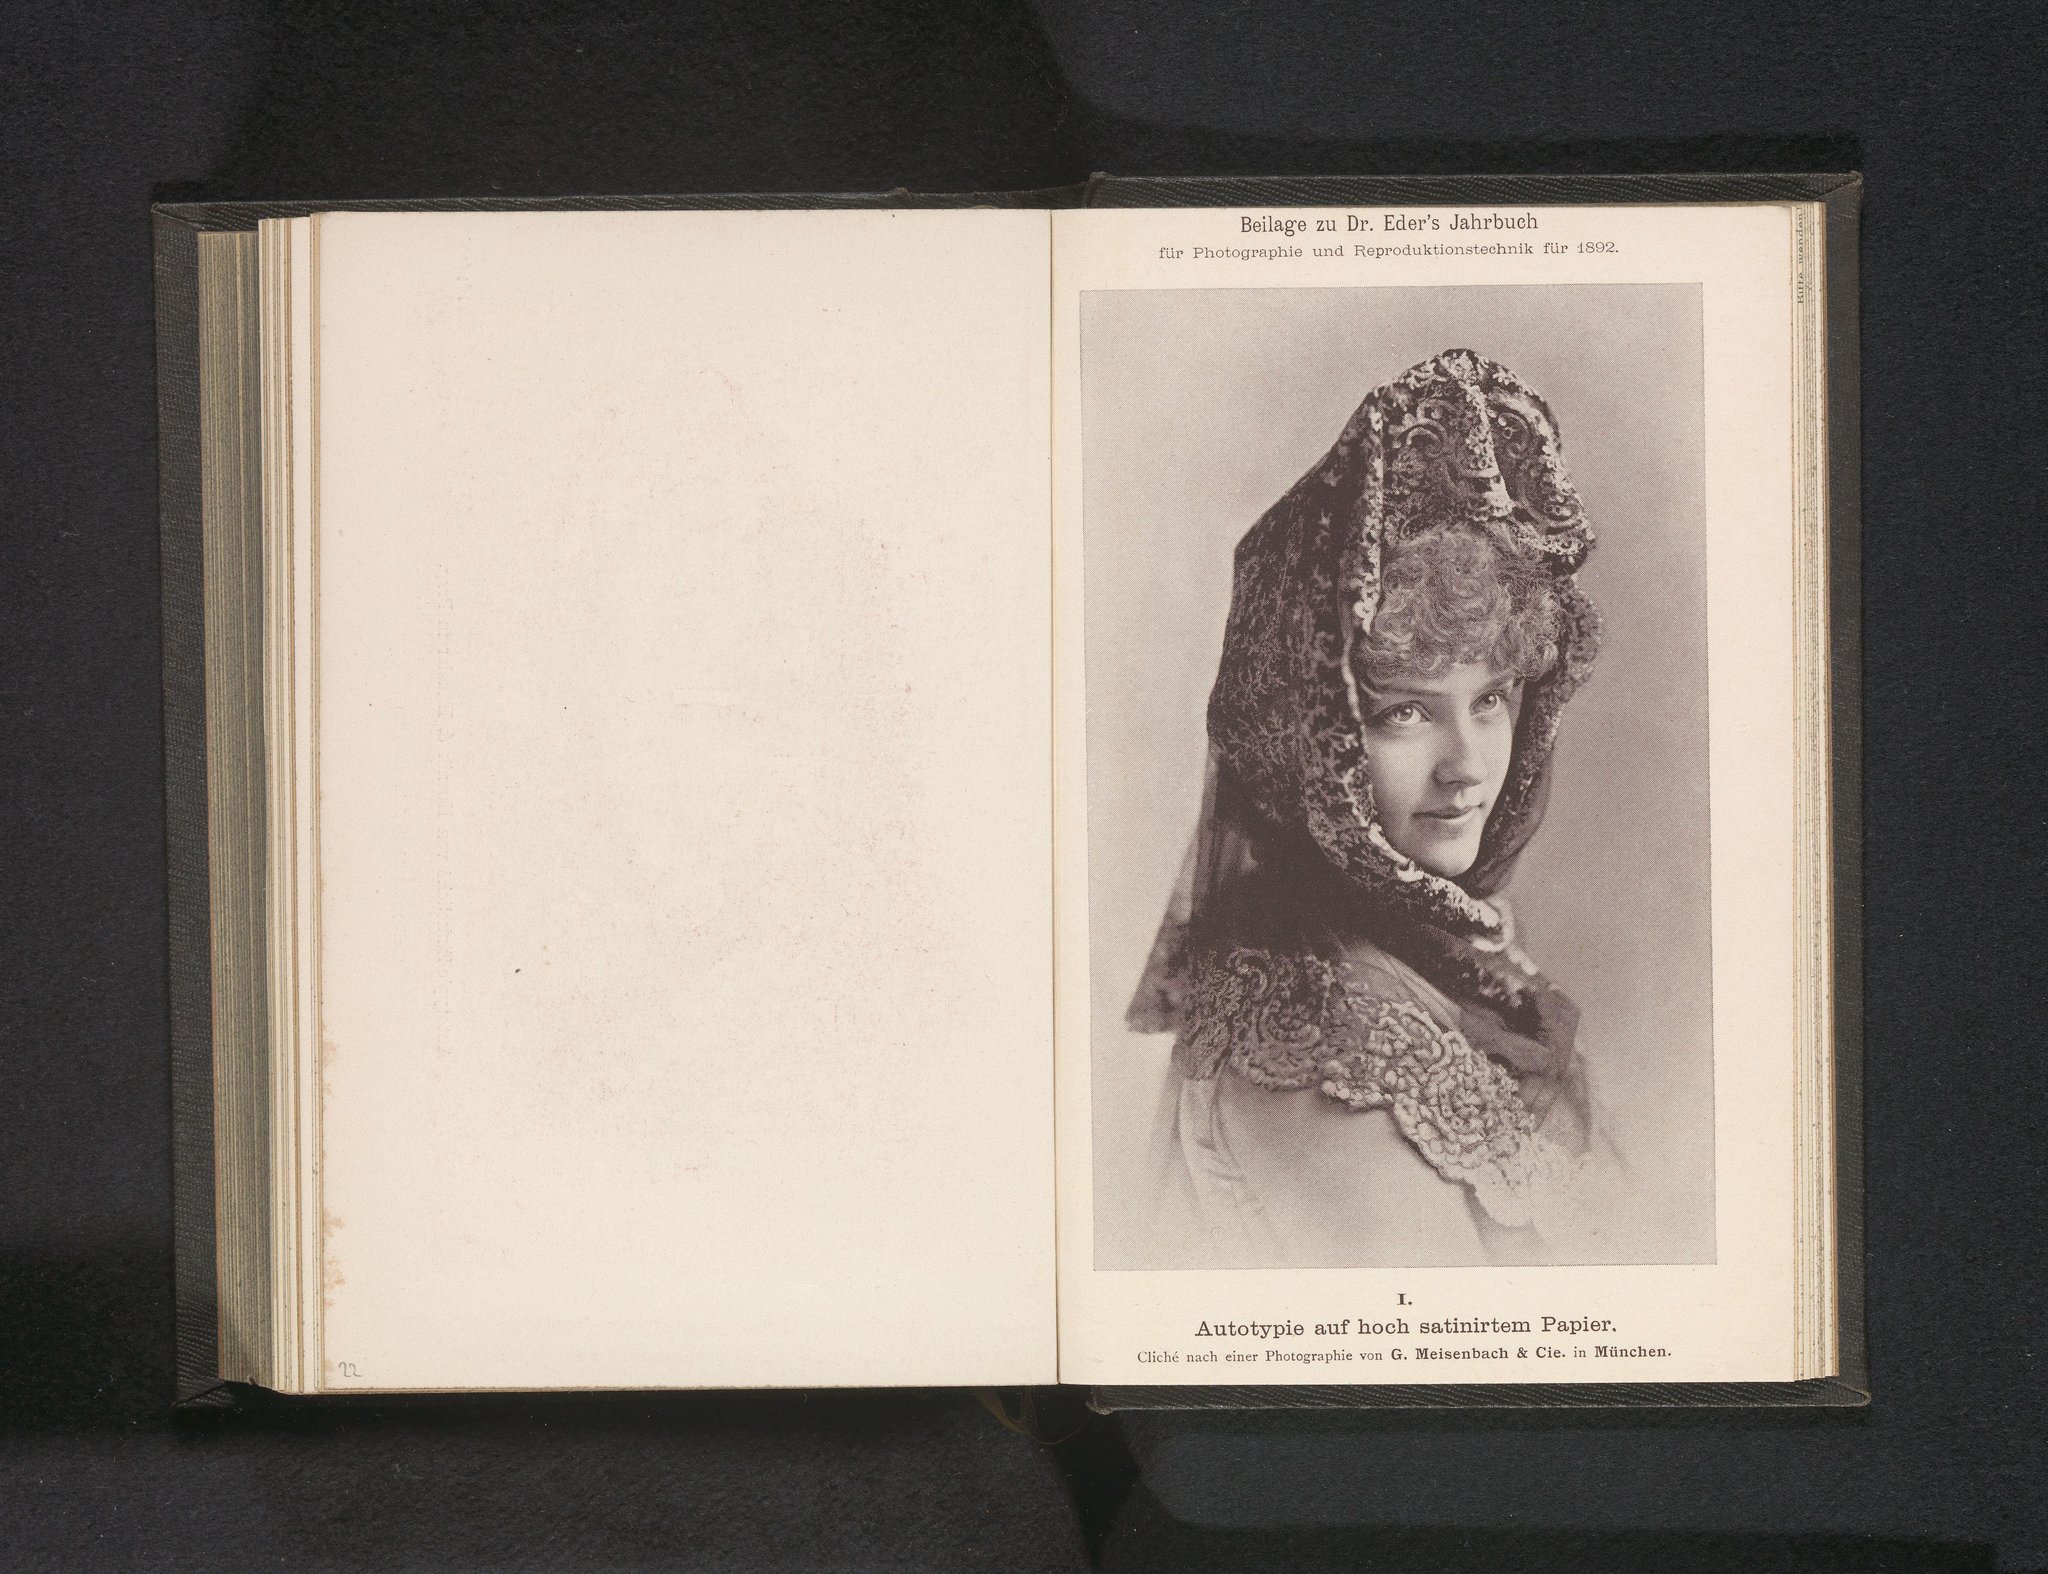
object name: photomechanical print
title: Portret van een onbekende vrouw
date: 1887-1892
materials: paper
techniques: autotype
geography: munich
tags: historical persons - bb - woman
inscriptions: inscription: ‘Beilage zu Eder's Jahrbuch 1892)/ für Photographie und Reproduktionistechnik für 1892./ I. Autotypie auf hoch satirntem Papier’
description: Prent op vijfenveertigste ongenummerde pagina na pagina 520.